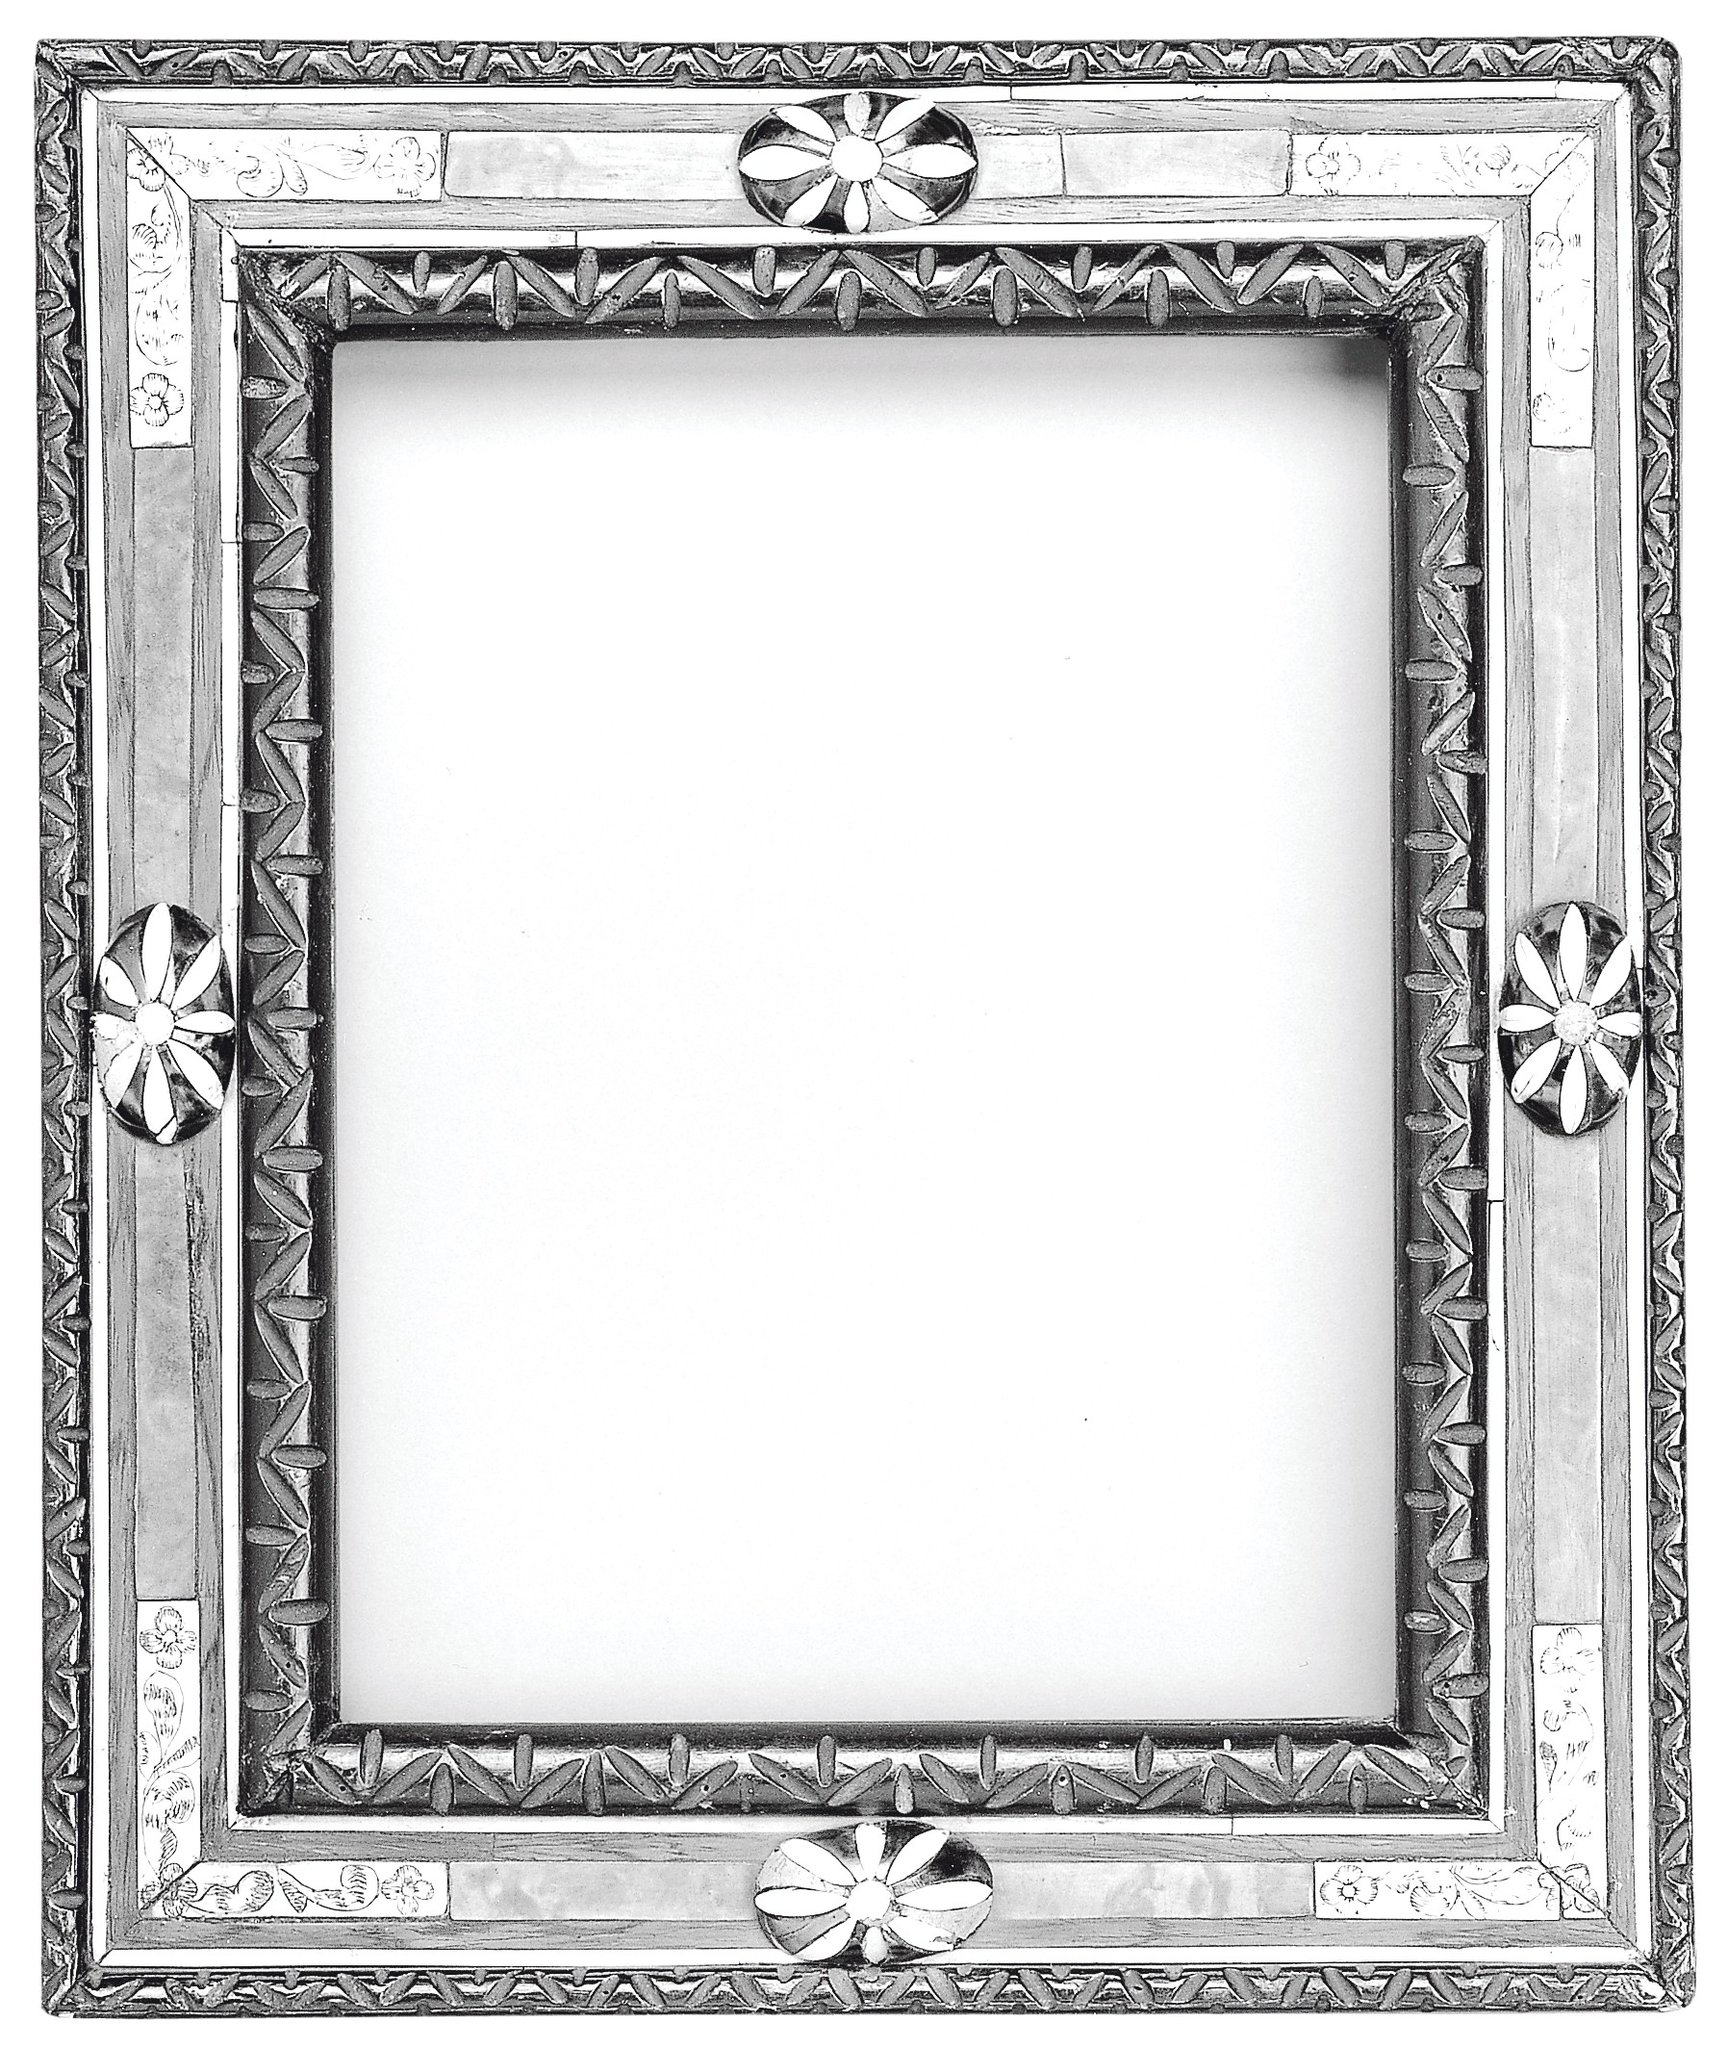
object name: frame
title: Cassetta frame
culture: american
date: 1901-1933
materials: ivory, wood, shell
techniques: carving, engraving, veneering